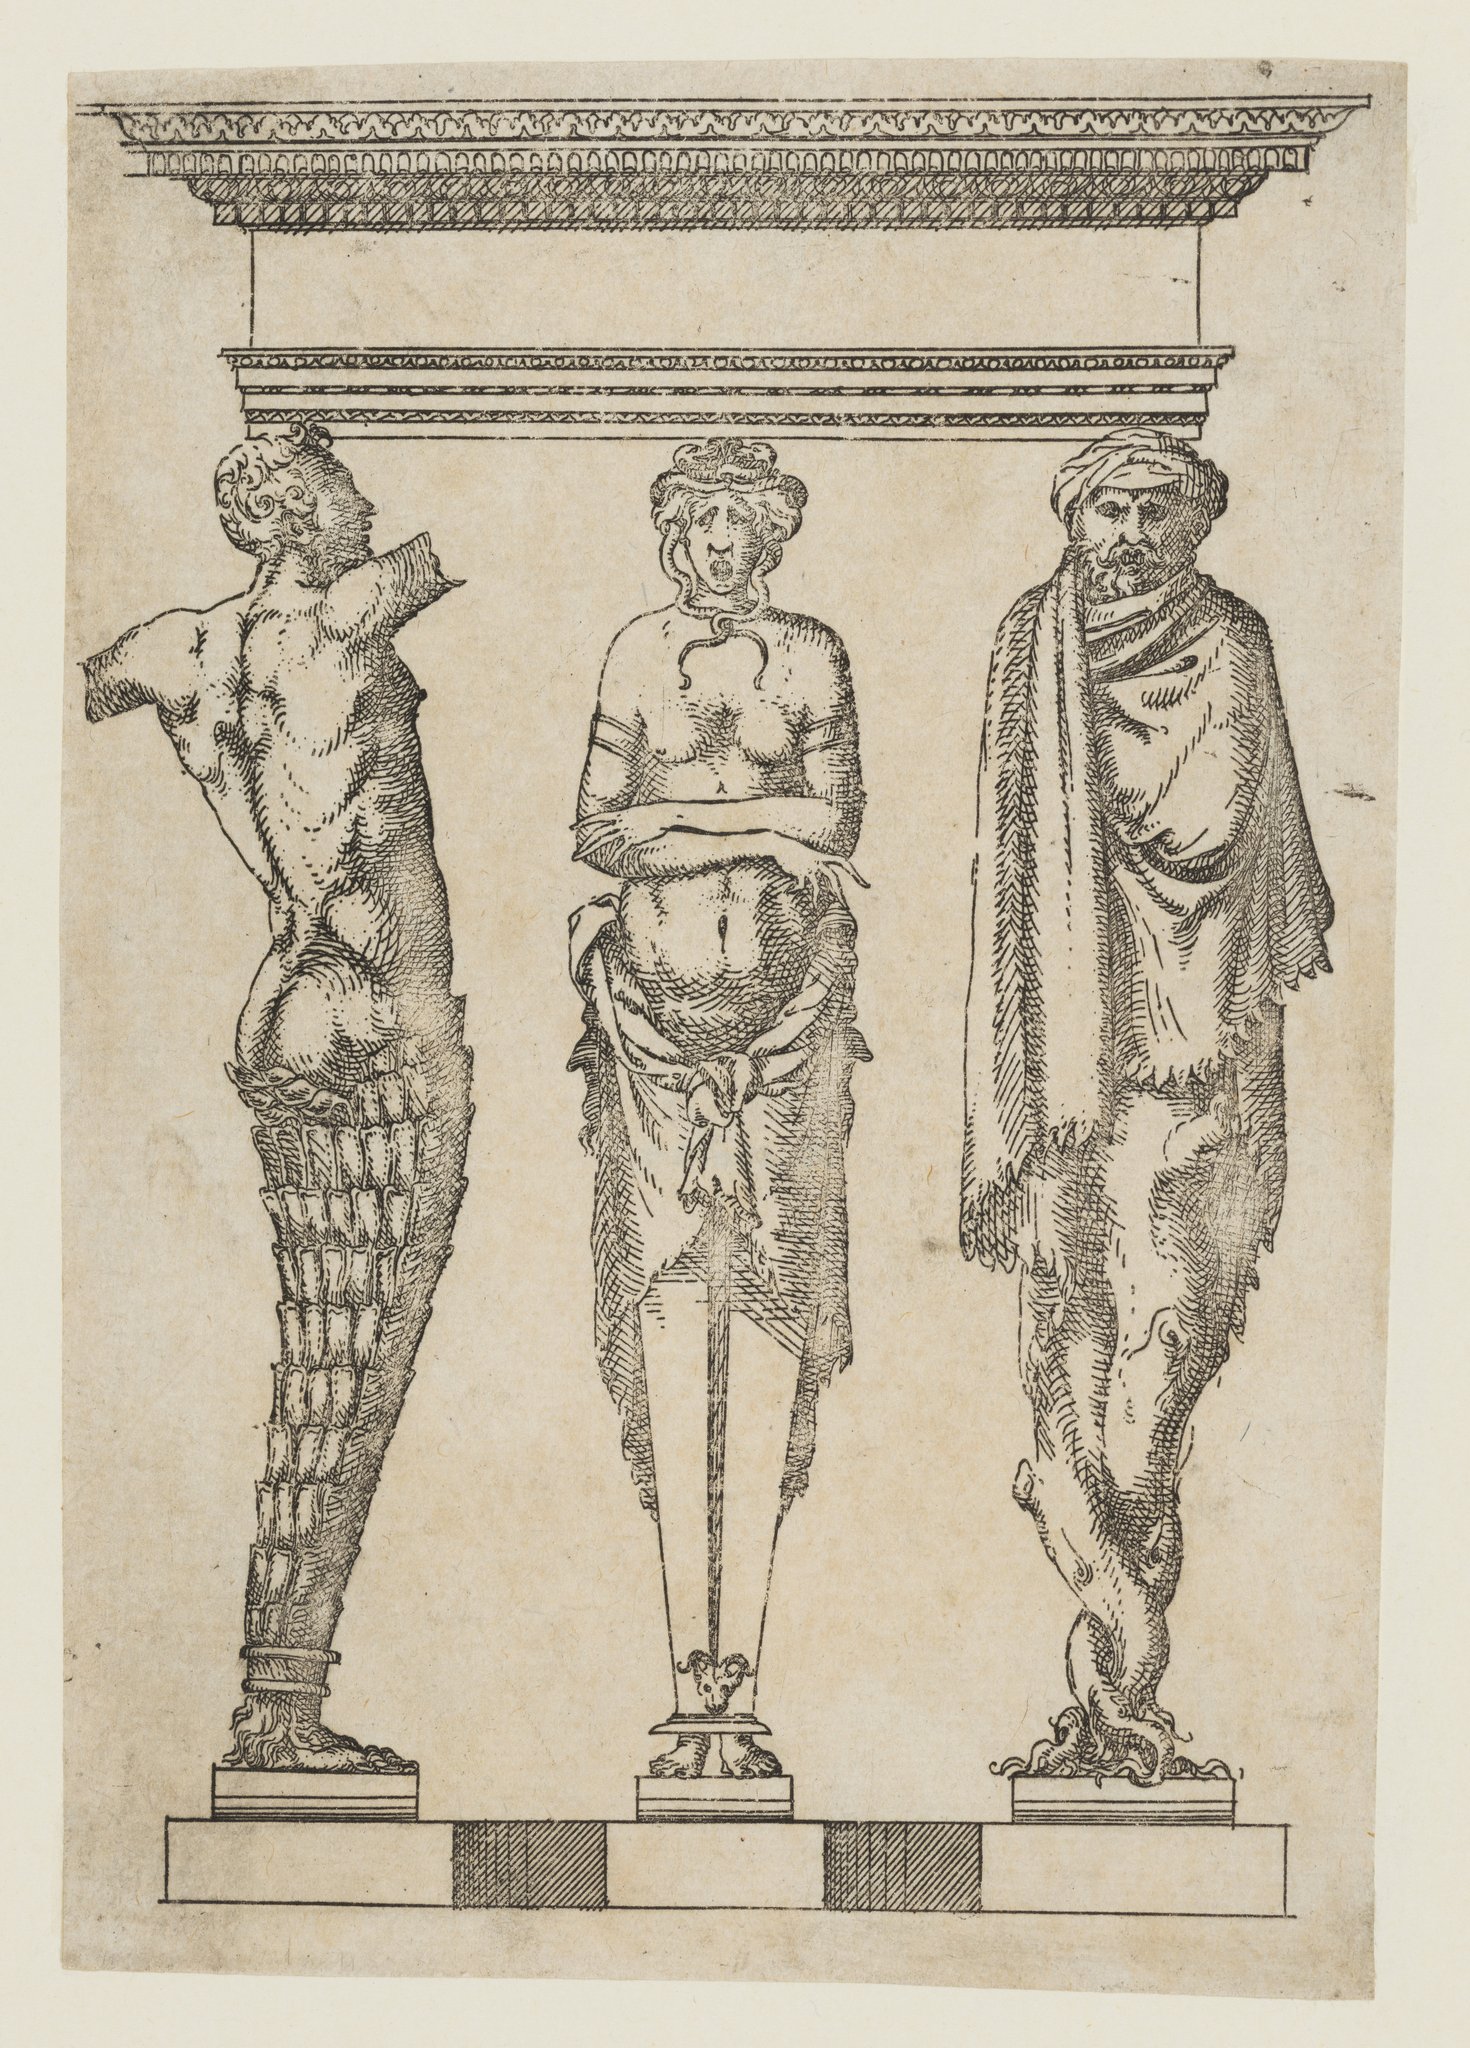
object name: book print ornament architecture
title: Designs for three terms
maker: jacques androuet du cerceau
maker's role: artist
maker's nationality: french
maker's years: 1510-1585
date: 1546-1549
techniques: etching